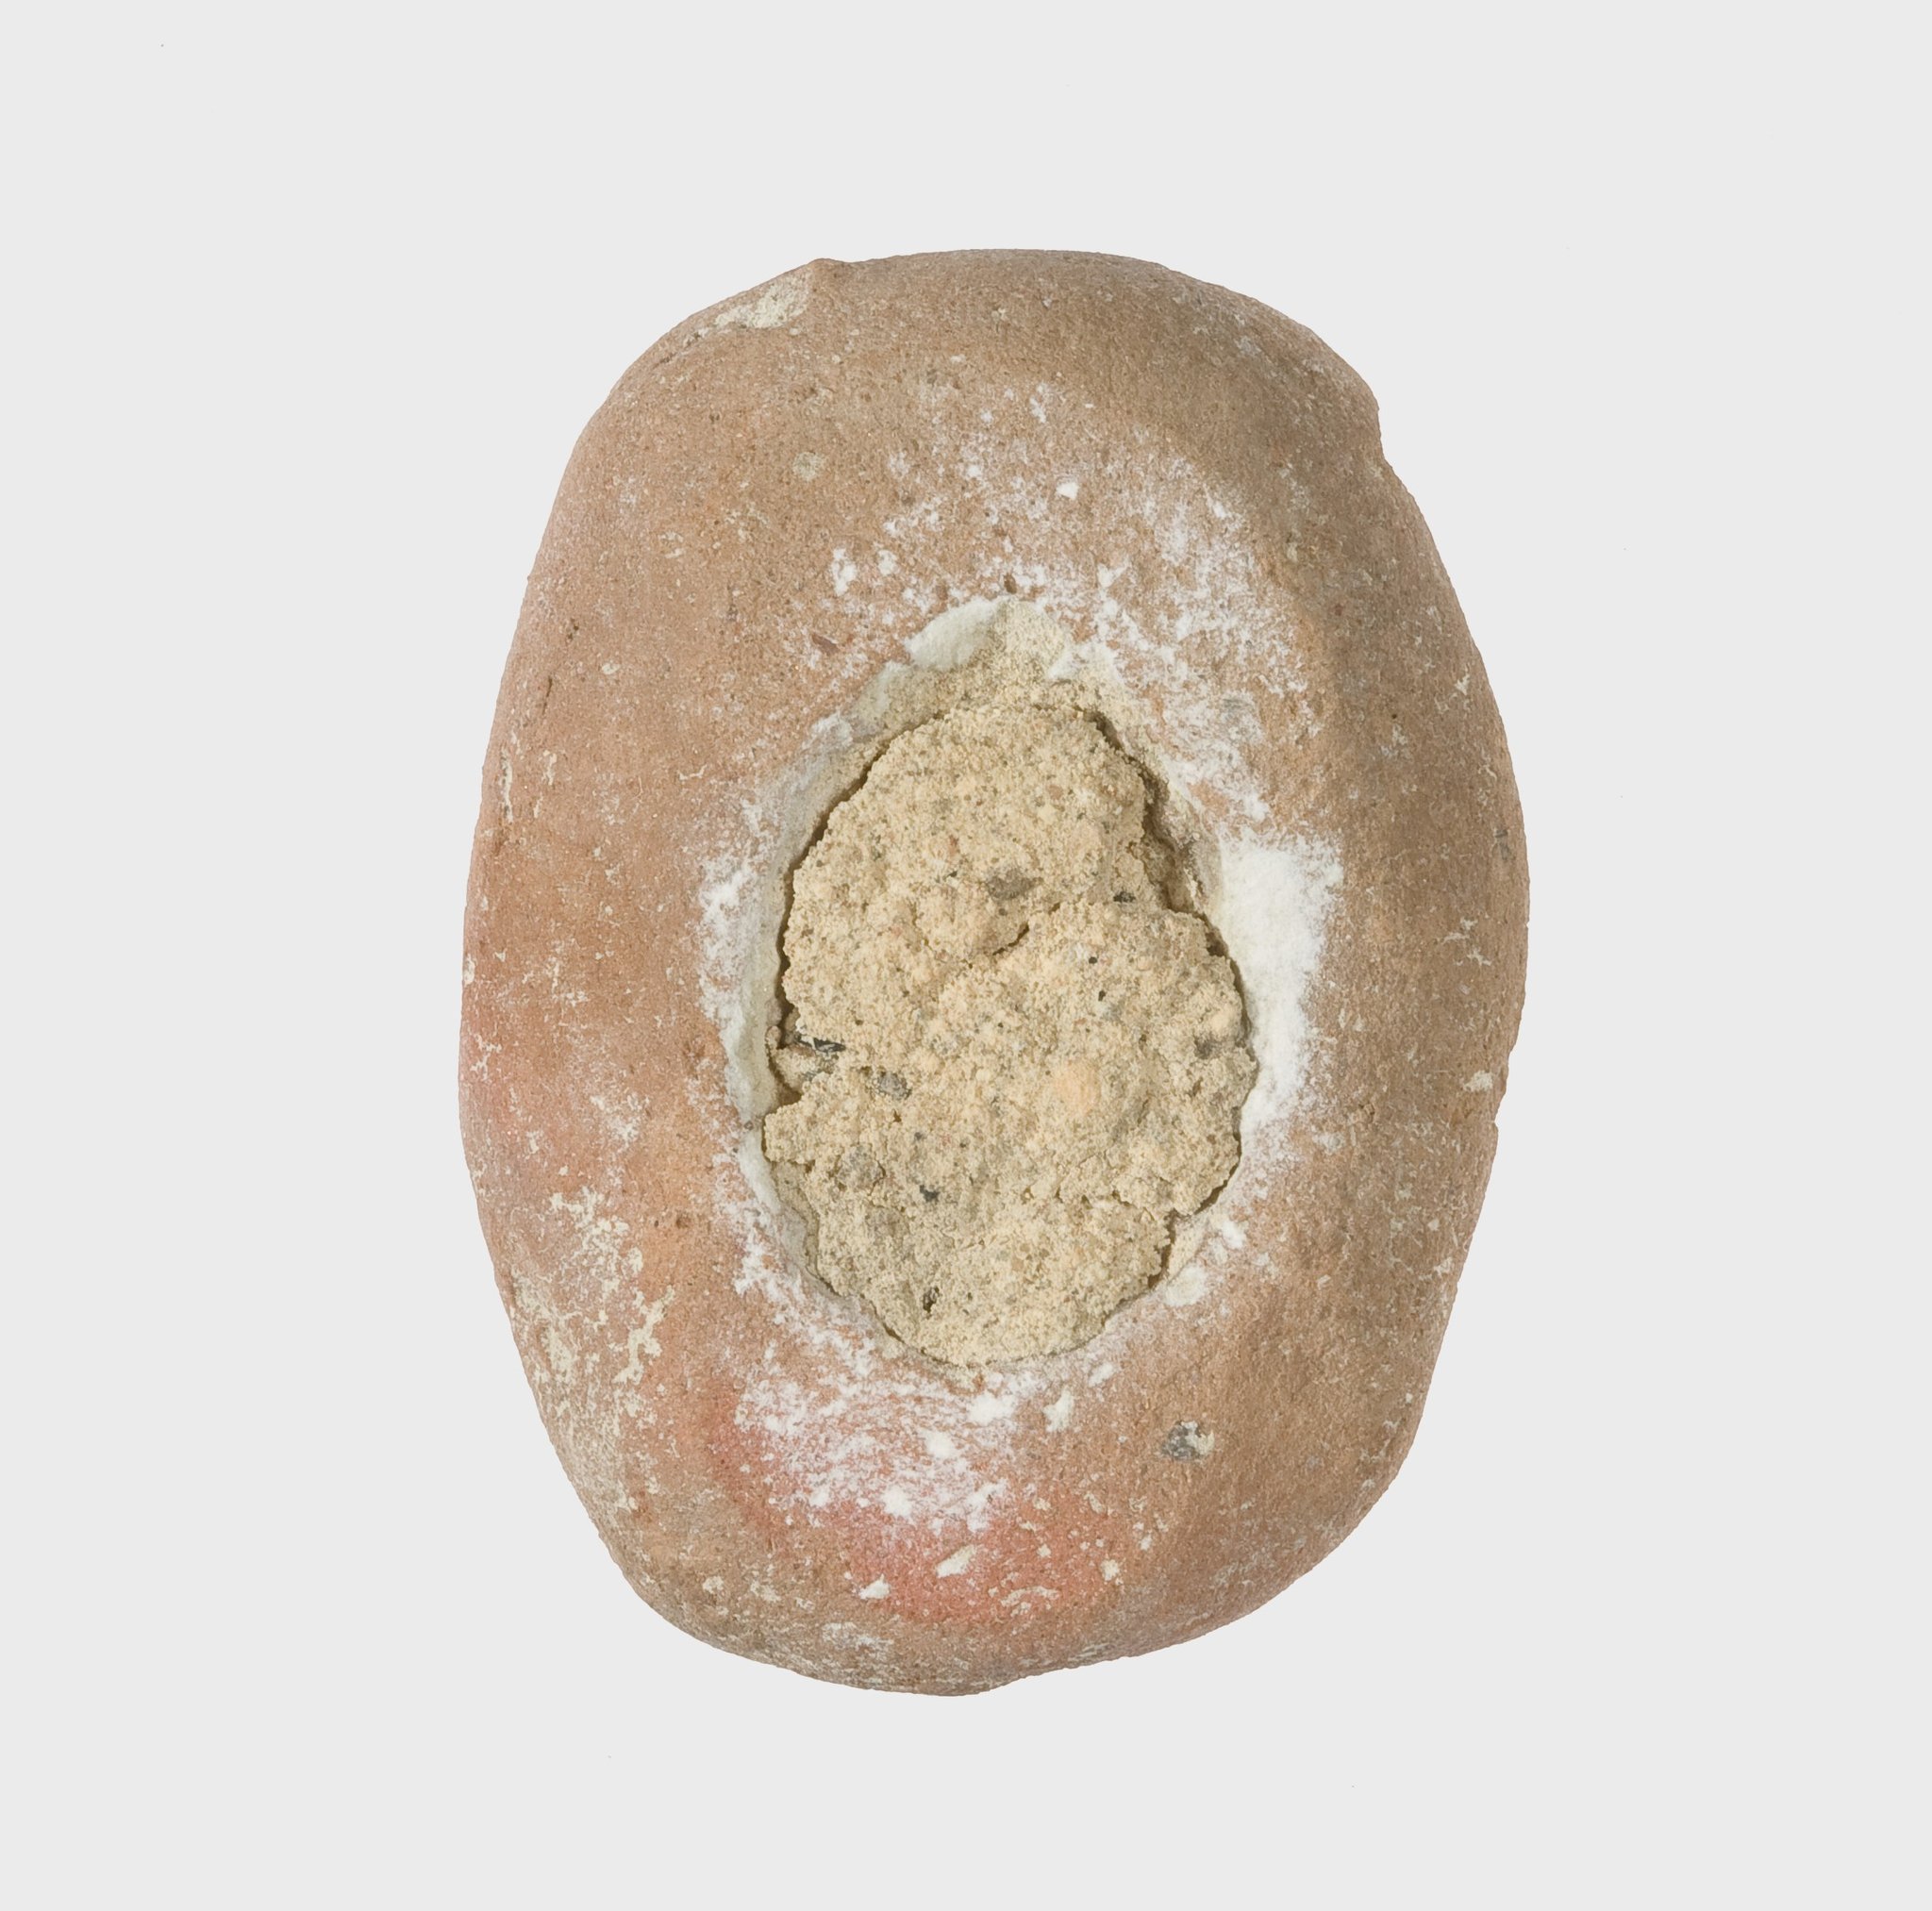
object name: mold, unfired frit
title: Mold with Unfired Frit Still Present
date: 1390-1352 BCE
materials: pottery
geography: egypt